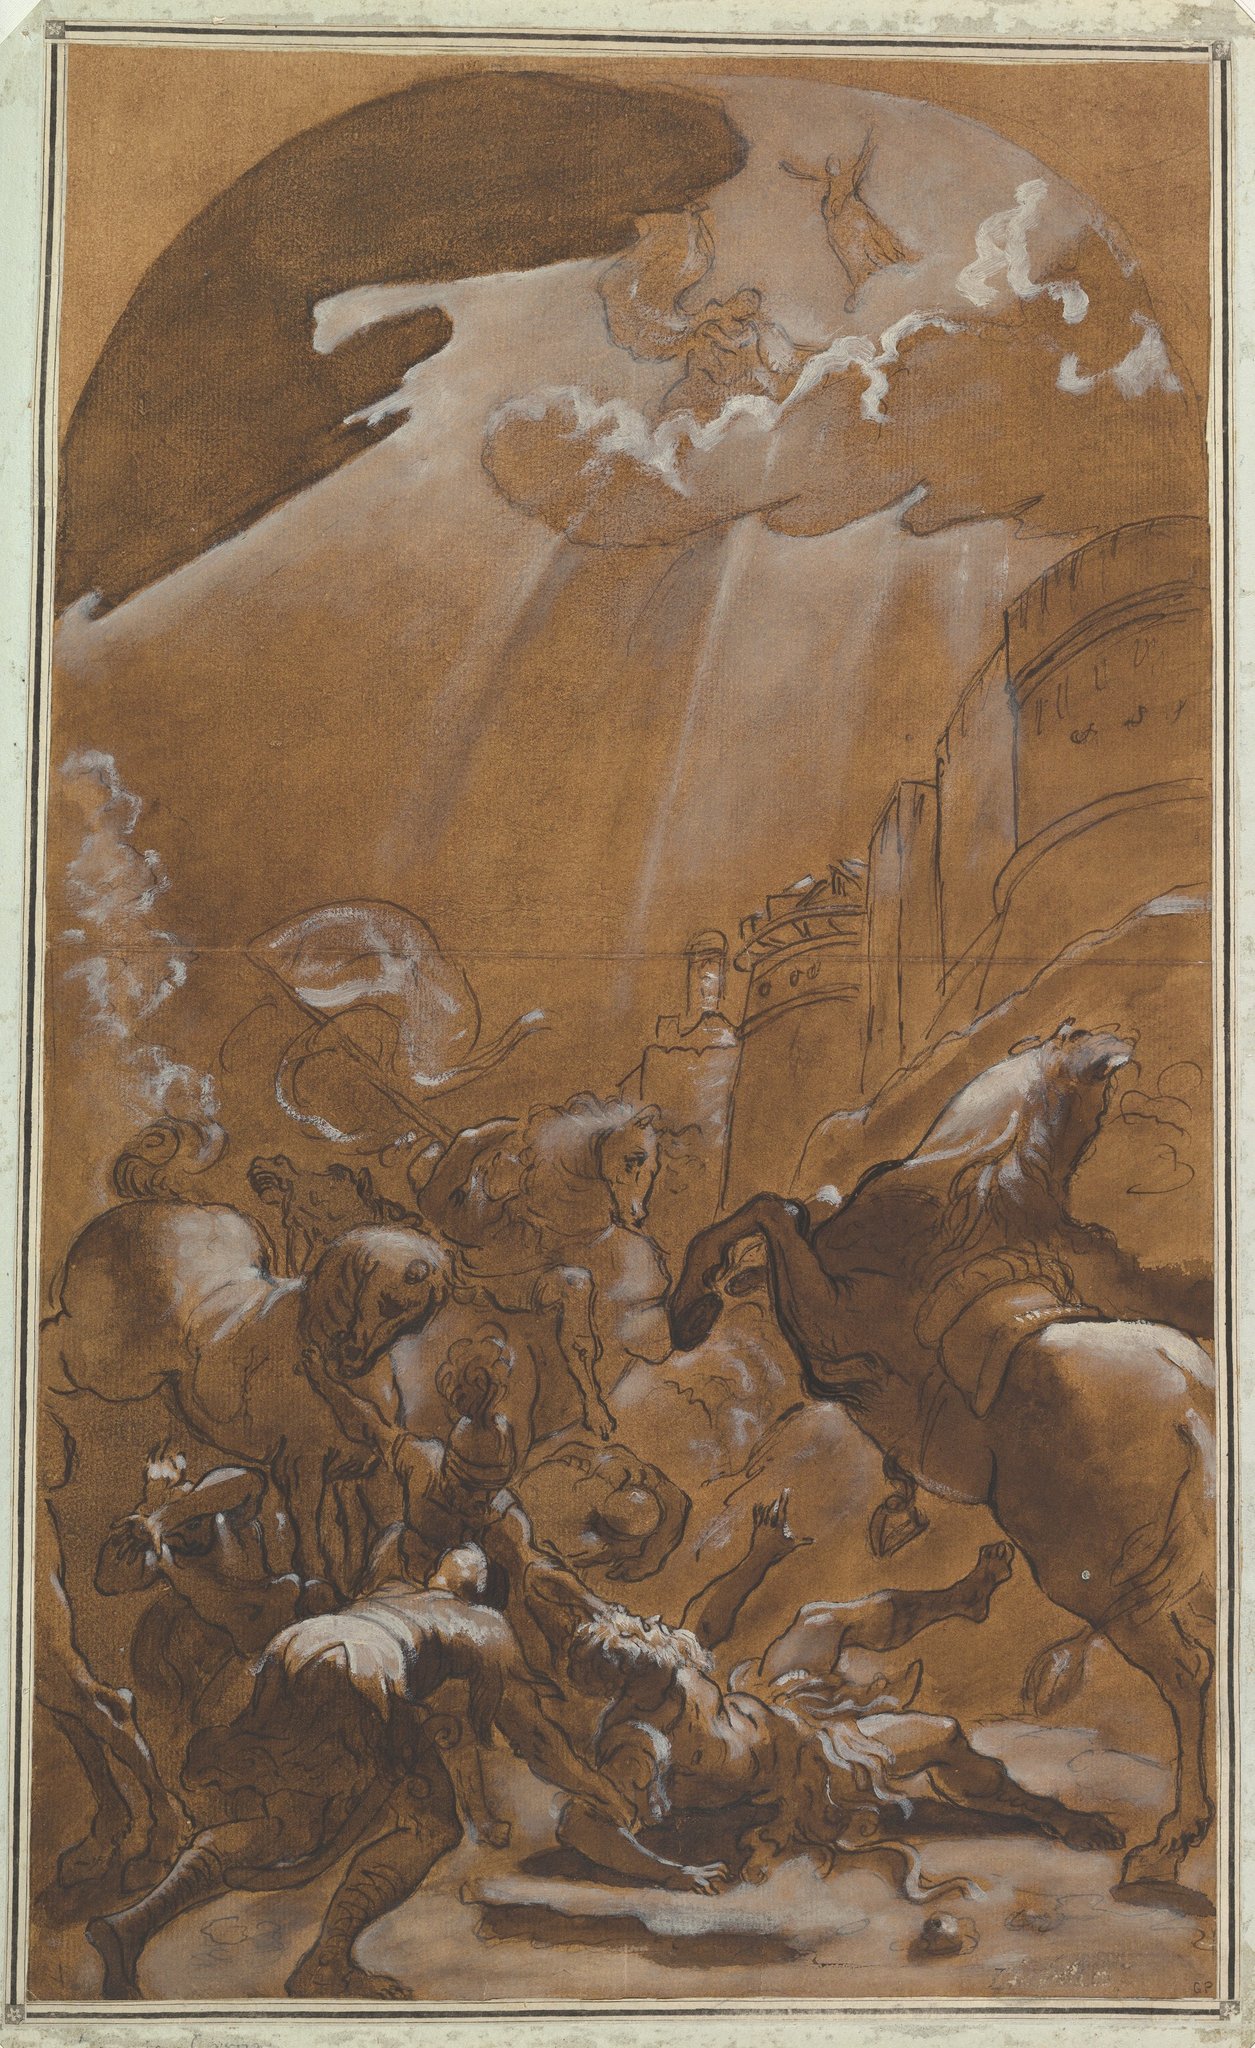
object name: drawing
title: The Conversion of Saint Paul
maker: ludovico carracci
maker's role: artist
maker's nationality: italian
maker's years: 1555-1619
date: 1587-1589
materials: chalk, gouache, ink, oil, paper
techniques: brush, heightening, pen, wash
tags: men,horses,saint paul